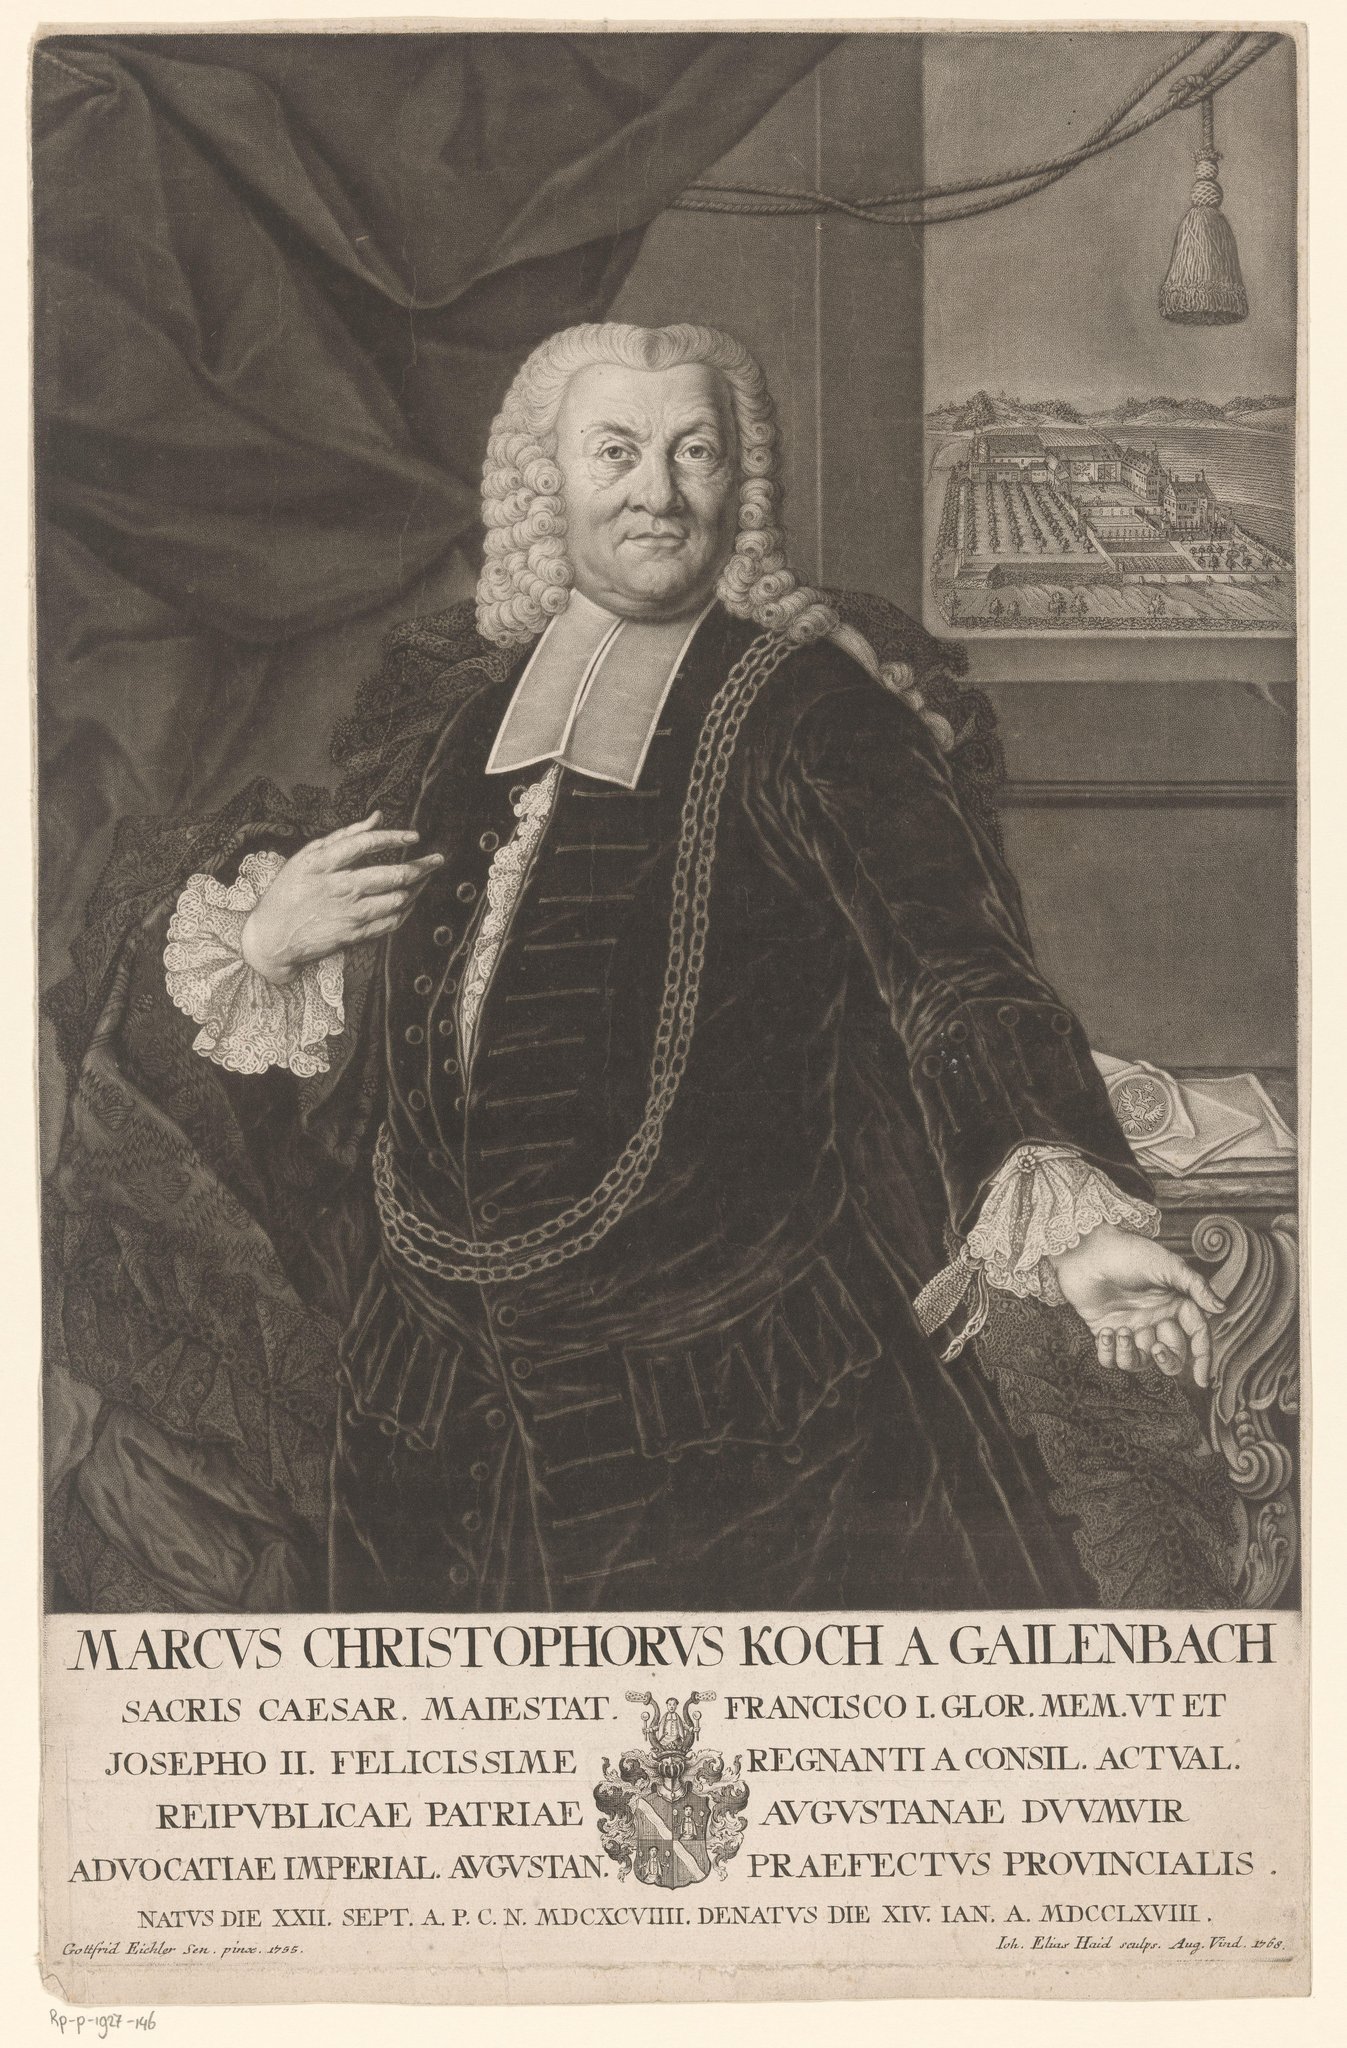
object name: print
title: Portret van Markus Christoph Koch von Gailenbach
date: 1755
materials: paper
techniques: mezzotint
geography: augsburg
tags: prospect of village, silhouette of village, historical persons, letter, envelope, governor, etc. of province, armorial bearing, heraldry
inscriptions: collector's mark: Lugt 2166